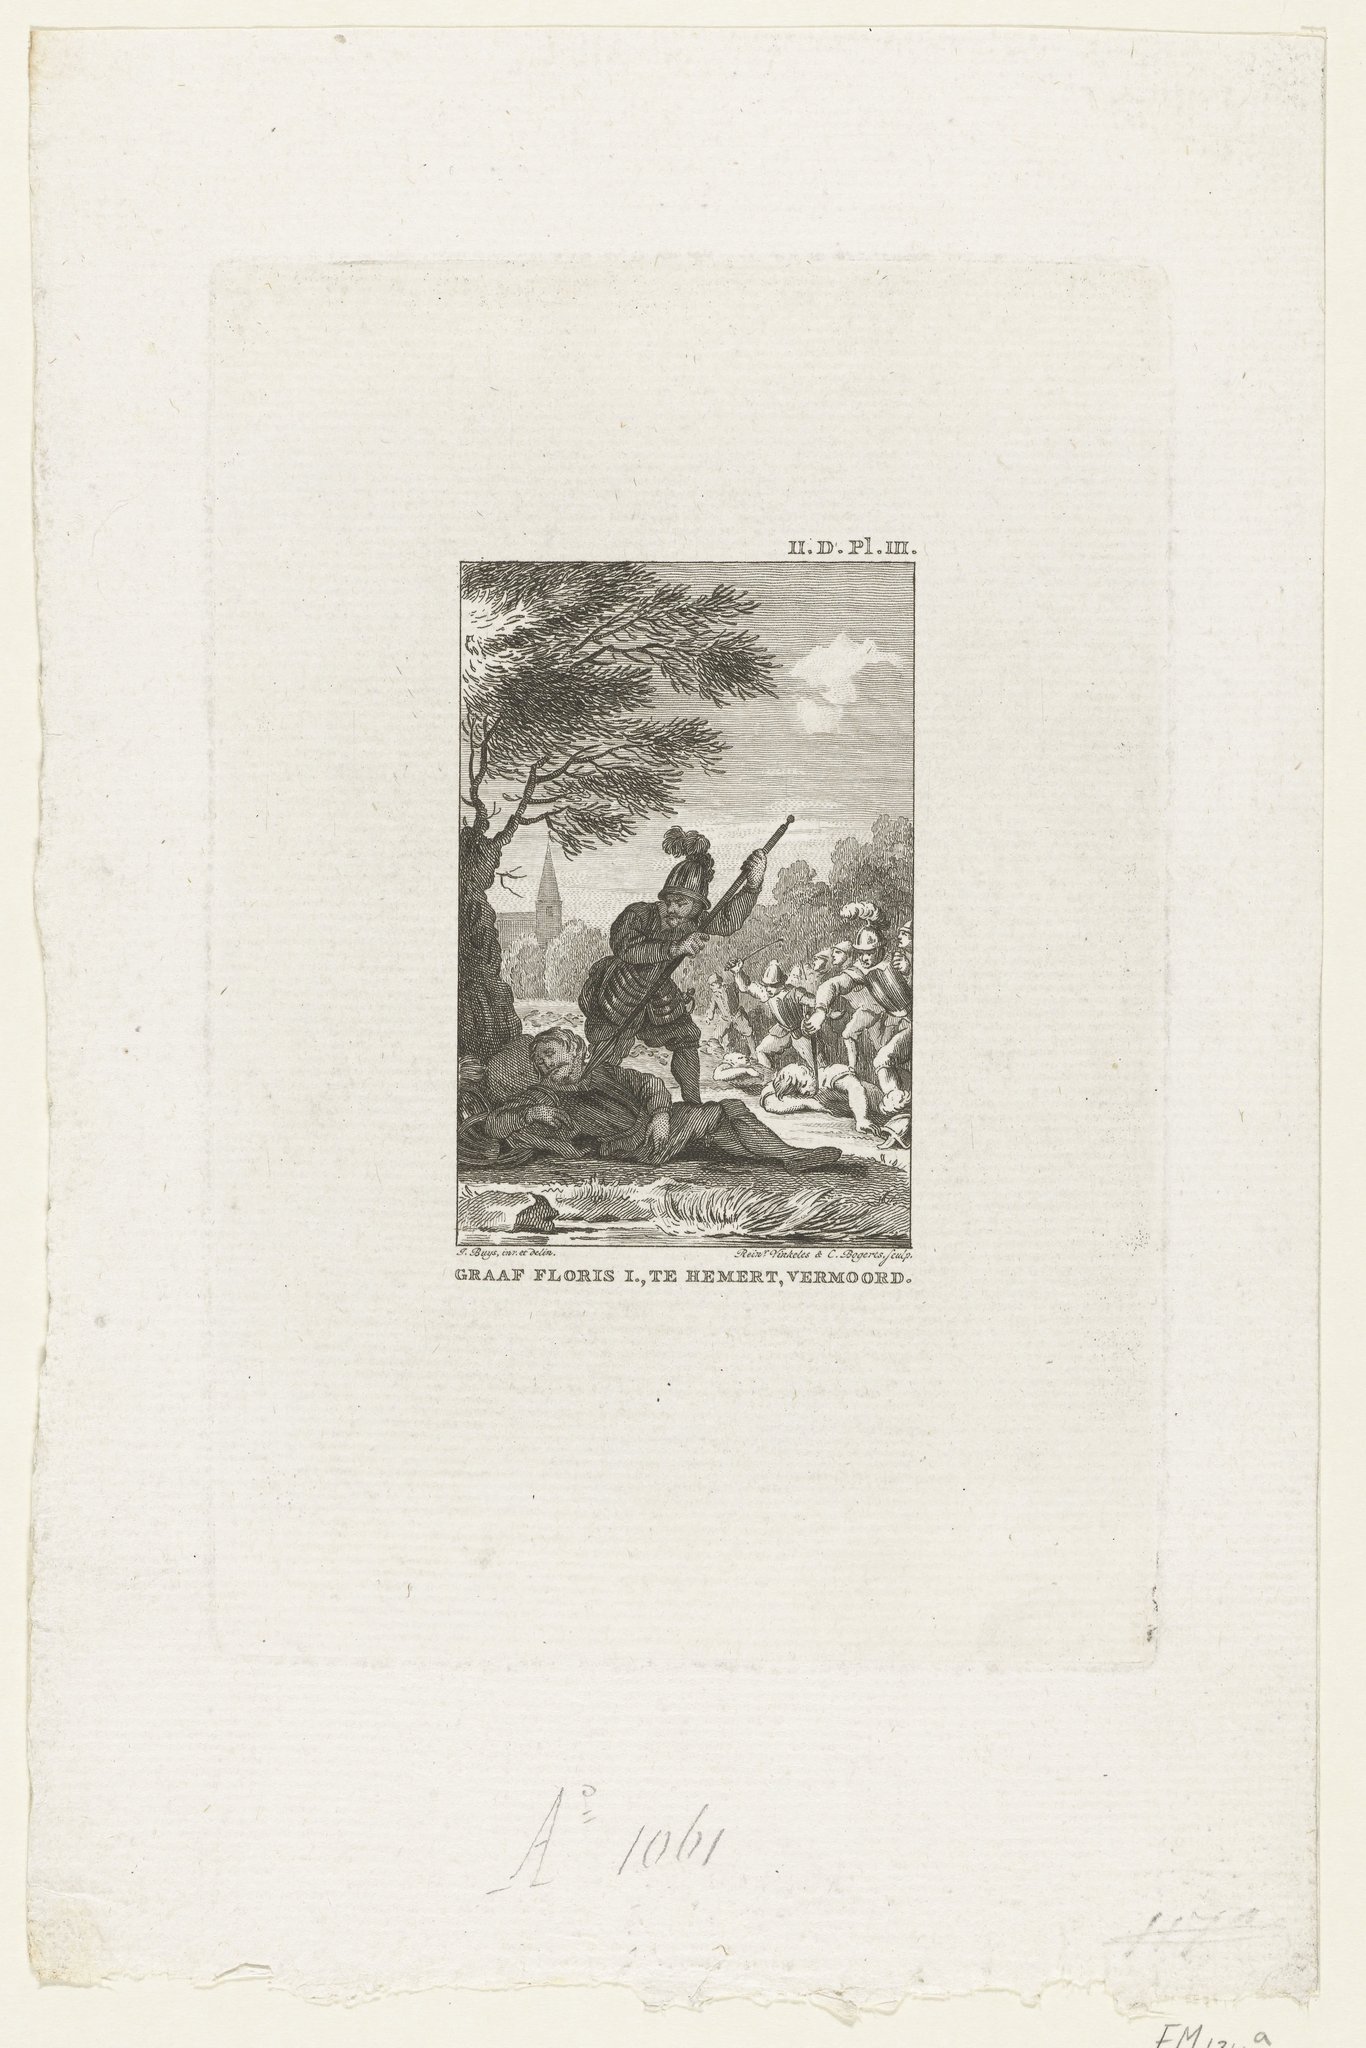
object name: print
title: Graaf Floris I, te Hemert, vermoord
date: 1780-1795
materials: paper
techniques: etching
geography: netherlands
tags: violent death, being killed; being mishandled and maltreated; seeking death, attempt, political murder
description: Illustratie voor: J. Fokke, Geschiedenissen der Vereenigde Nederlanden voor de vaderlandsche jeugd, Johannes Allart, Amsterdam 1783-1795, 25 delen, dl. II, pl. III. Staat met de letter.